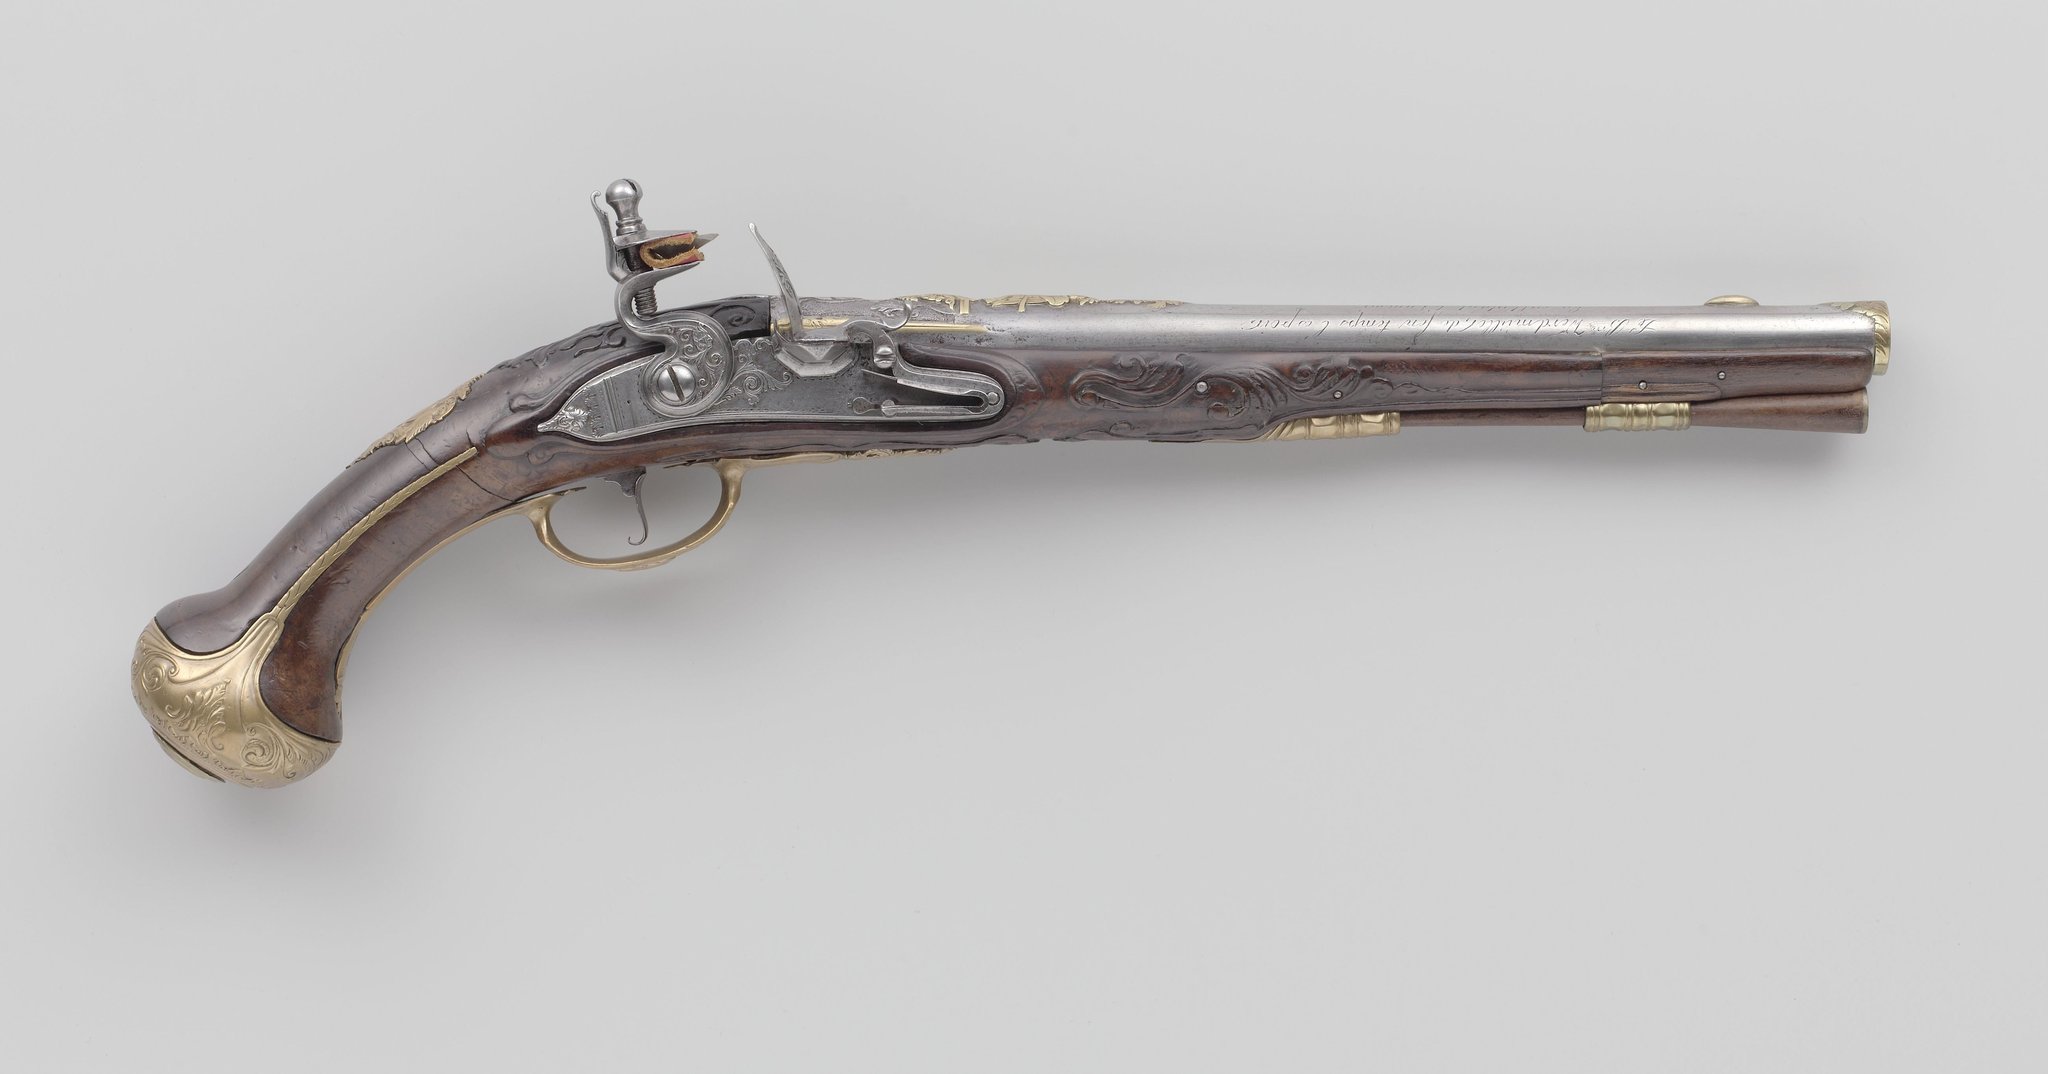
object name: flintlock pistol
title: Vuursteenpistool met batterijslot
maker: Anonymous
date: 1709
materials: brass, steel, wood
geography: utrecht